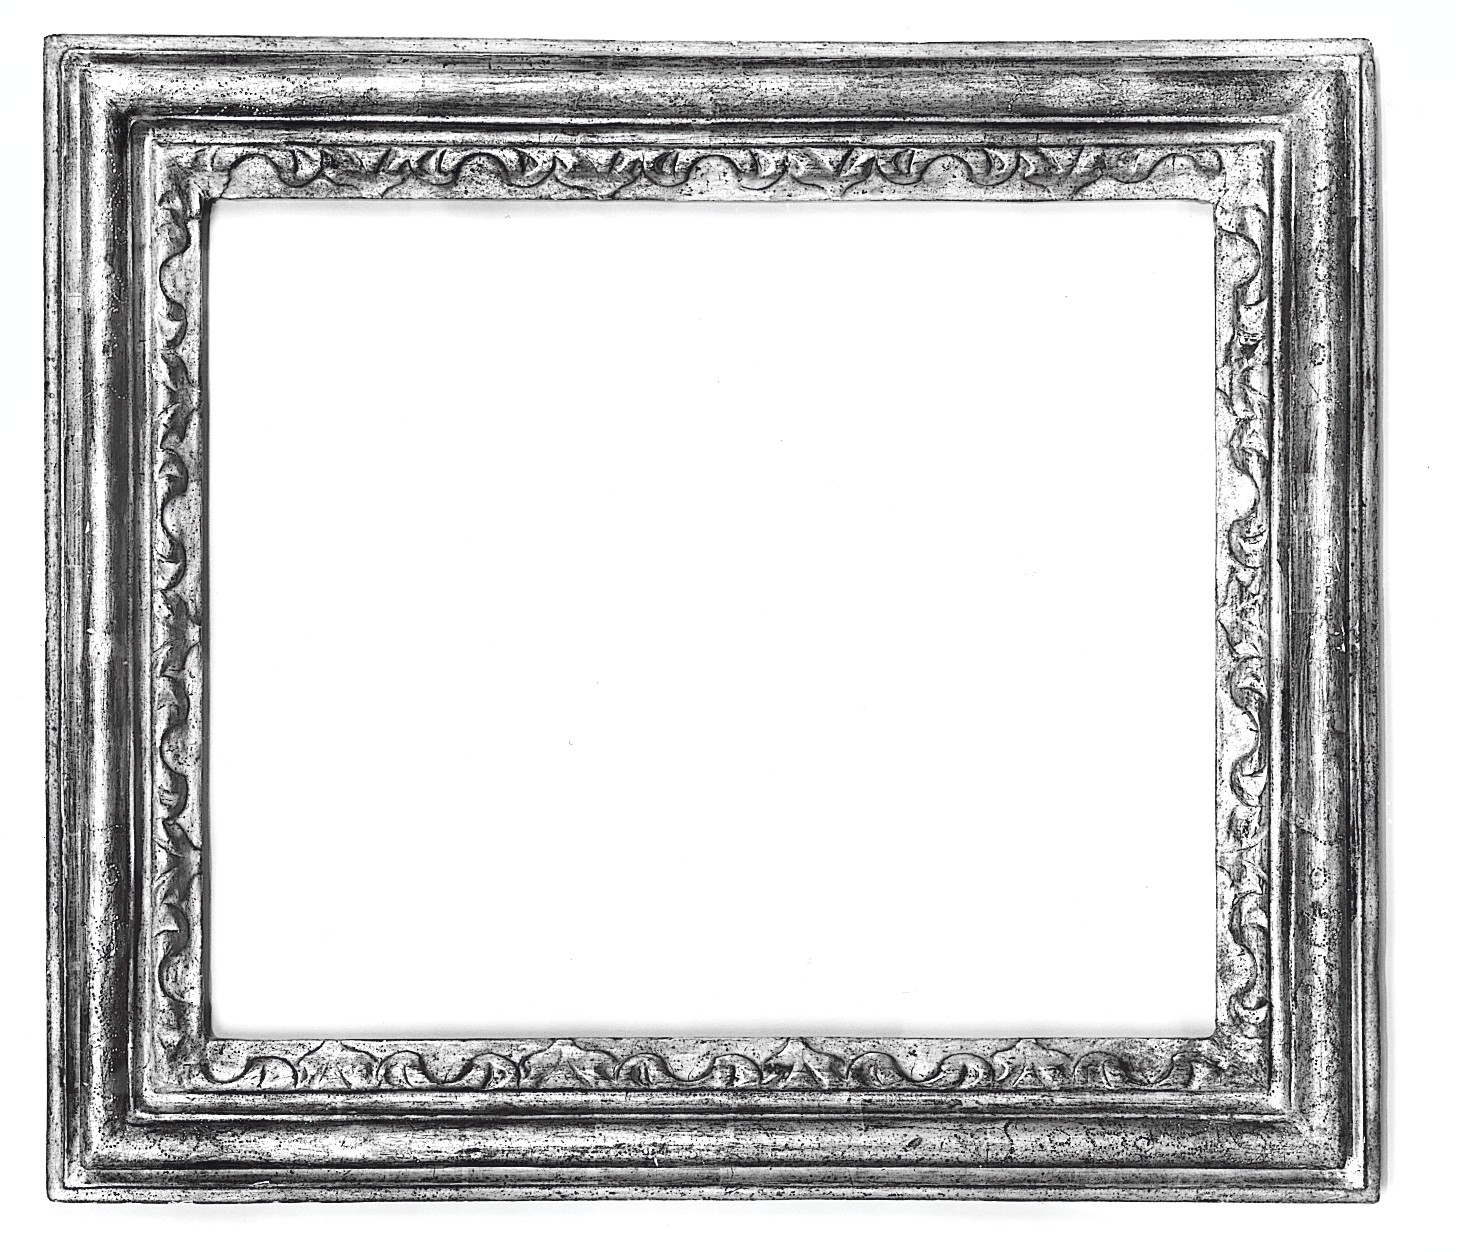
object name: frame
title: Salvator Rosa frame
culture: italian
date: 1734-1766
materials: wood